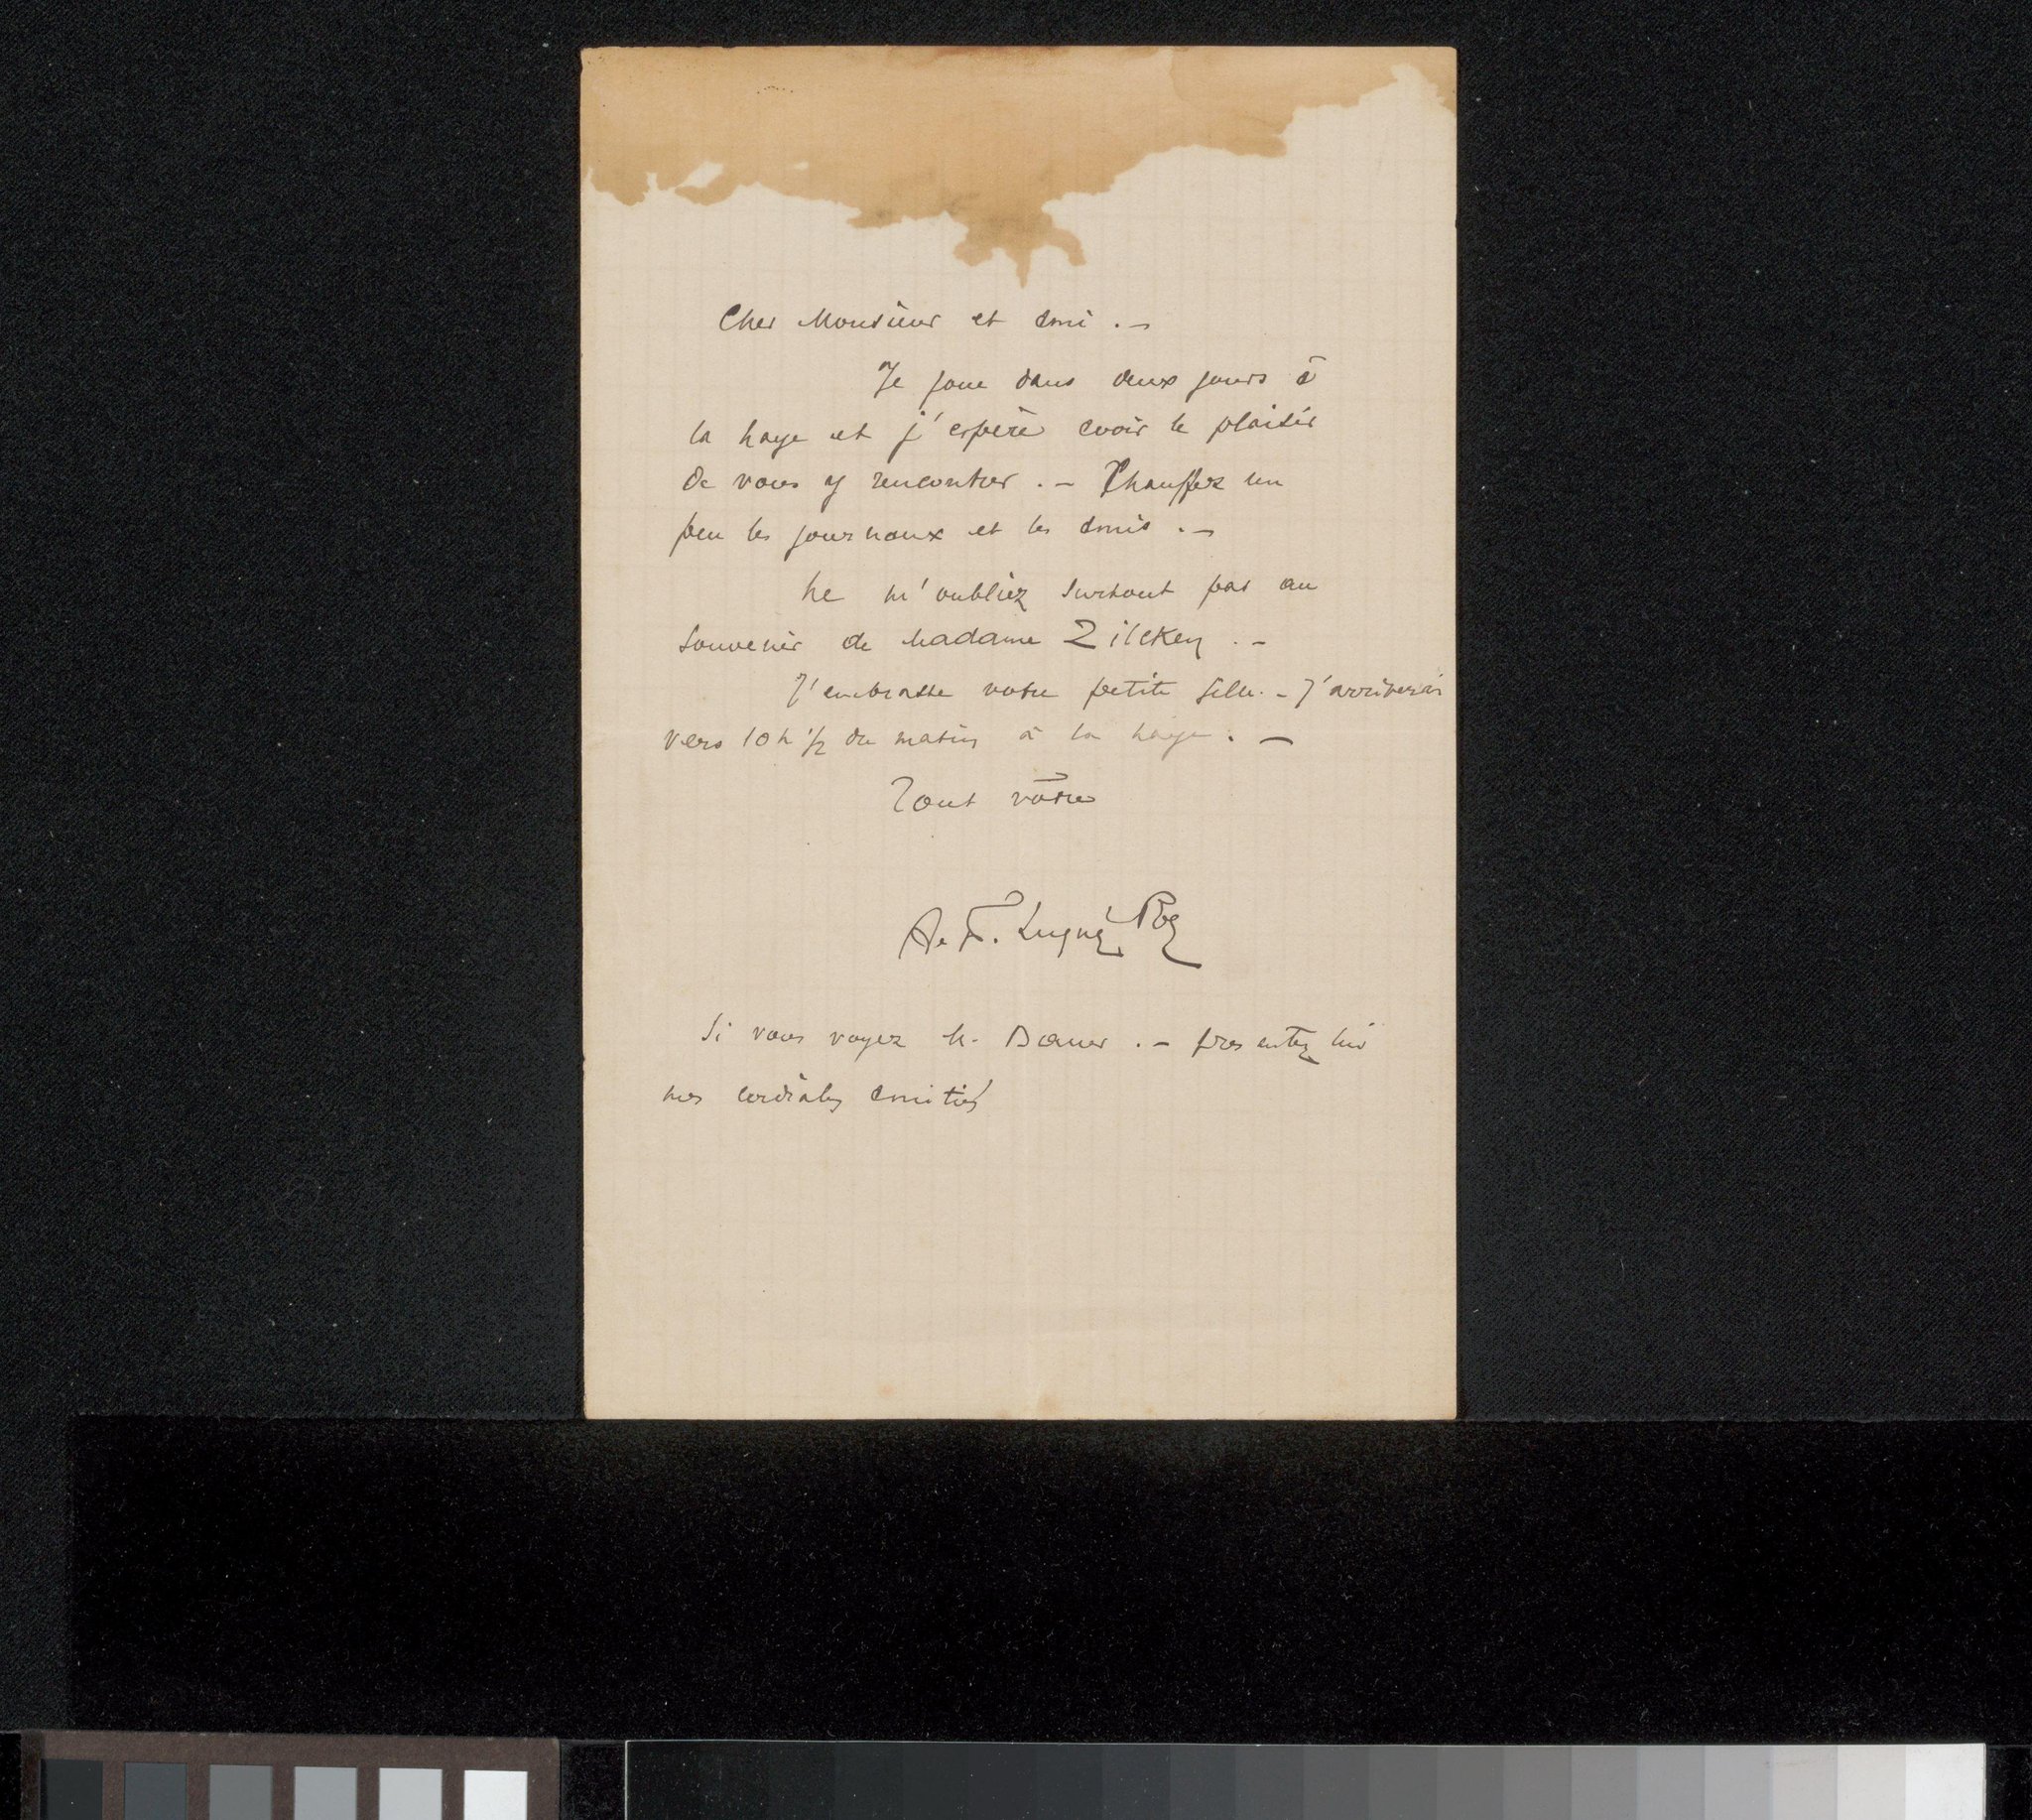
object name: letter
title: Brief aan Philip Zilcken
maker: lugné-poe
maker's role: acteur, theaterdirecteur, theatervormgever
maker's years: 1869-1940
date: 1879-1930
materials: ink, paper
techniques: pen, writing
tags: painter, draughtsman, philip zilcken, the hague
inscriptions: collector's mark: ‘RPK’